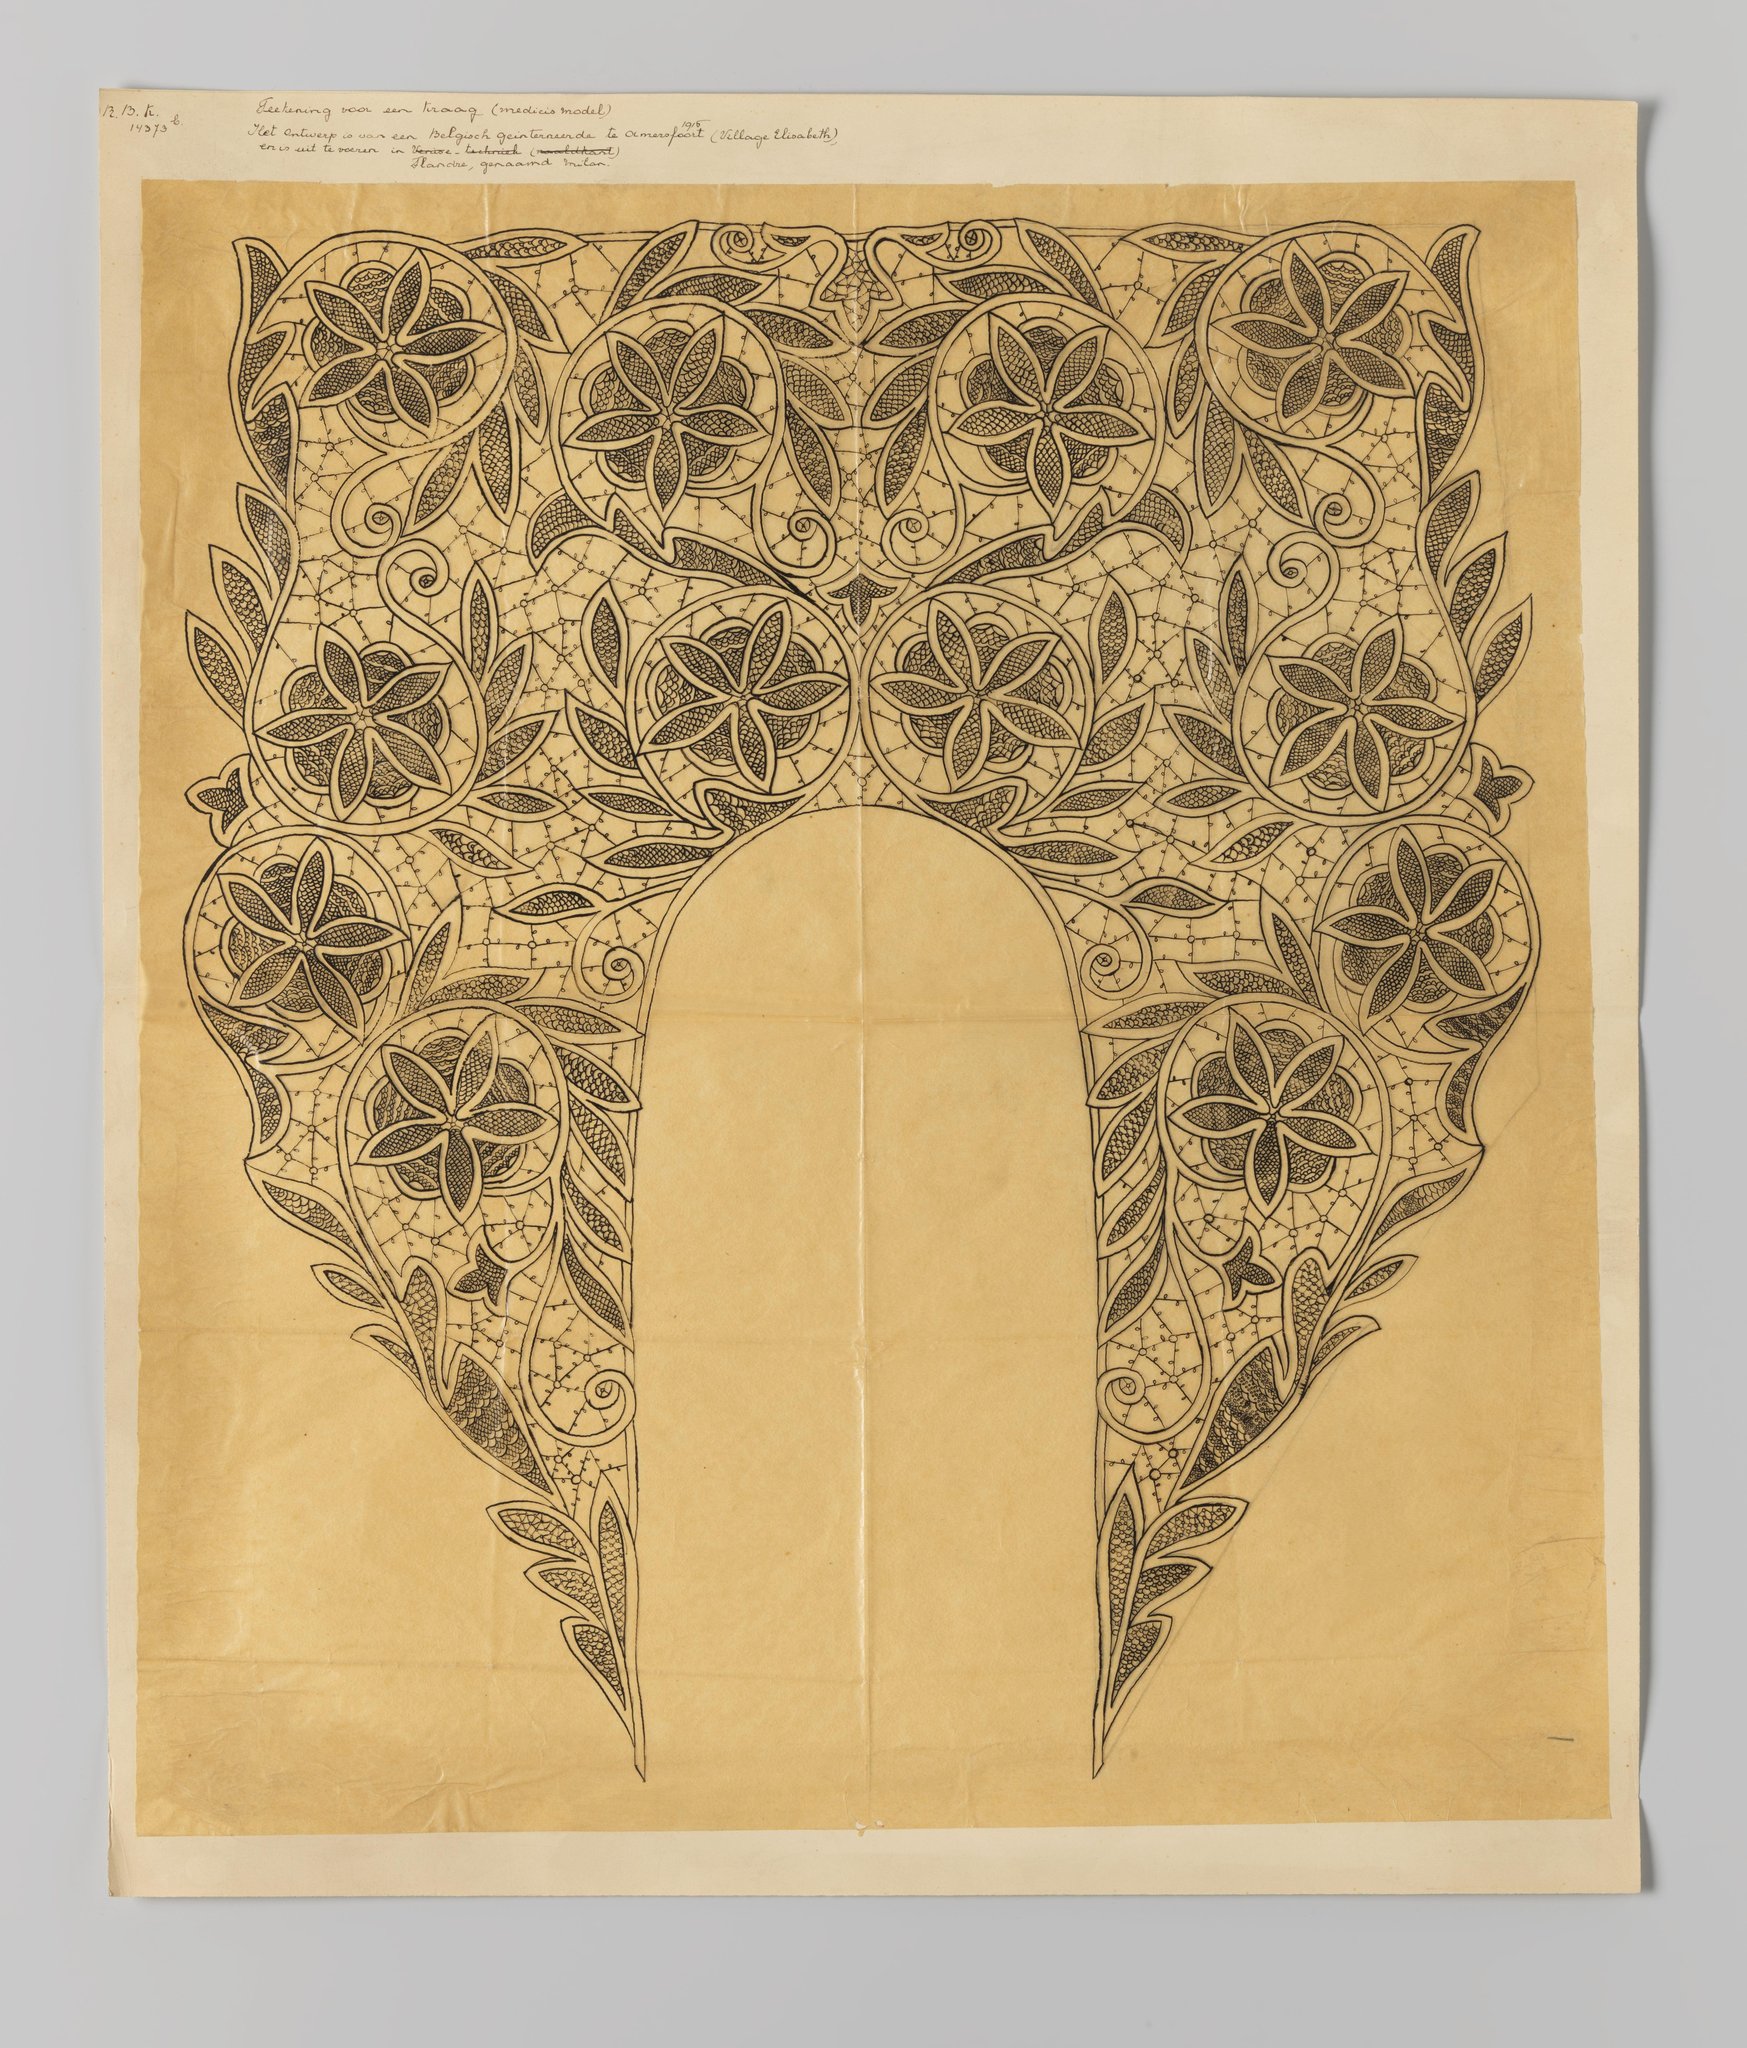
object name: working drawing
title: Naaldkantpatroon voor een u-vormige kraag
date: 1915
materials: ink, paper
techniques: drawing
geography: amersfoort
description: Naaldkantpatroon voor een kraag van naaldkant met inkt getekend op transparant papier en opgeplakt op karton. De kraag heeft een u-vormig model waarbij de onderkant aan de buitenzijde niet rond maar afgeplat is wat een rechthoekige achterzijde oplevert en met scherpe punten aan de voorkant. Het ontwerp van de kraag is gemaakt door een persoon uit België die in de Eerste Wereldoorlog was geïnterneerd in kamp 'Elisabeth-dorp' in Amersfoort.